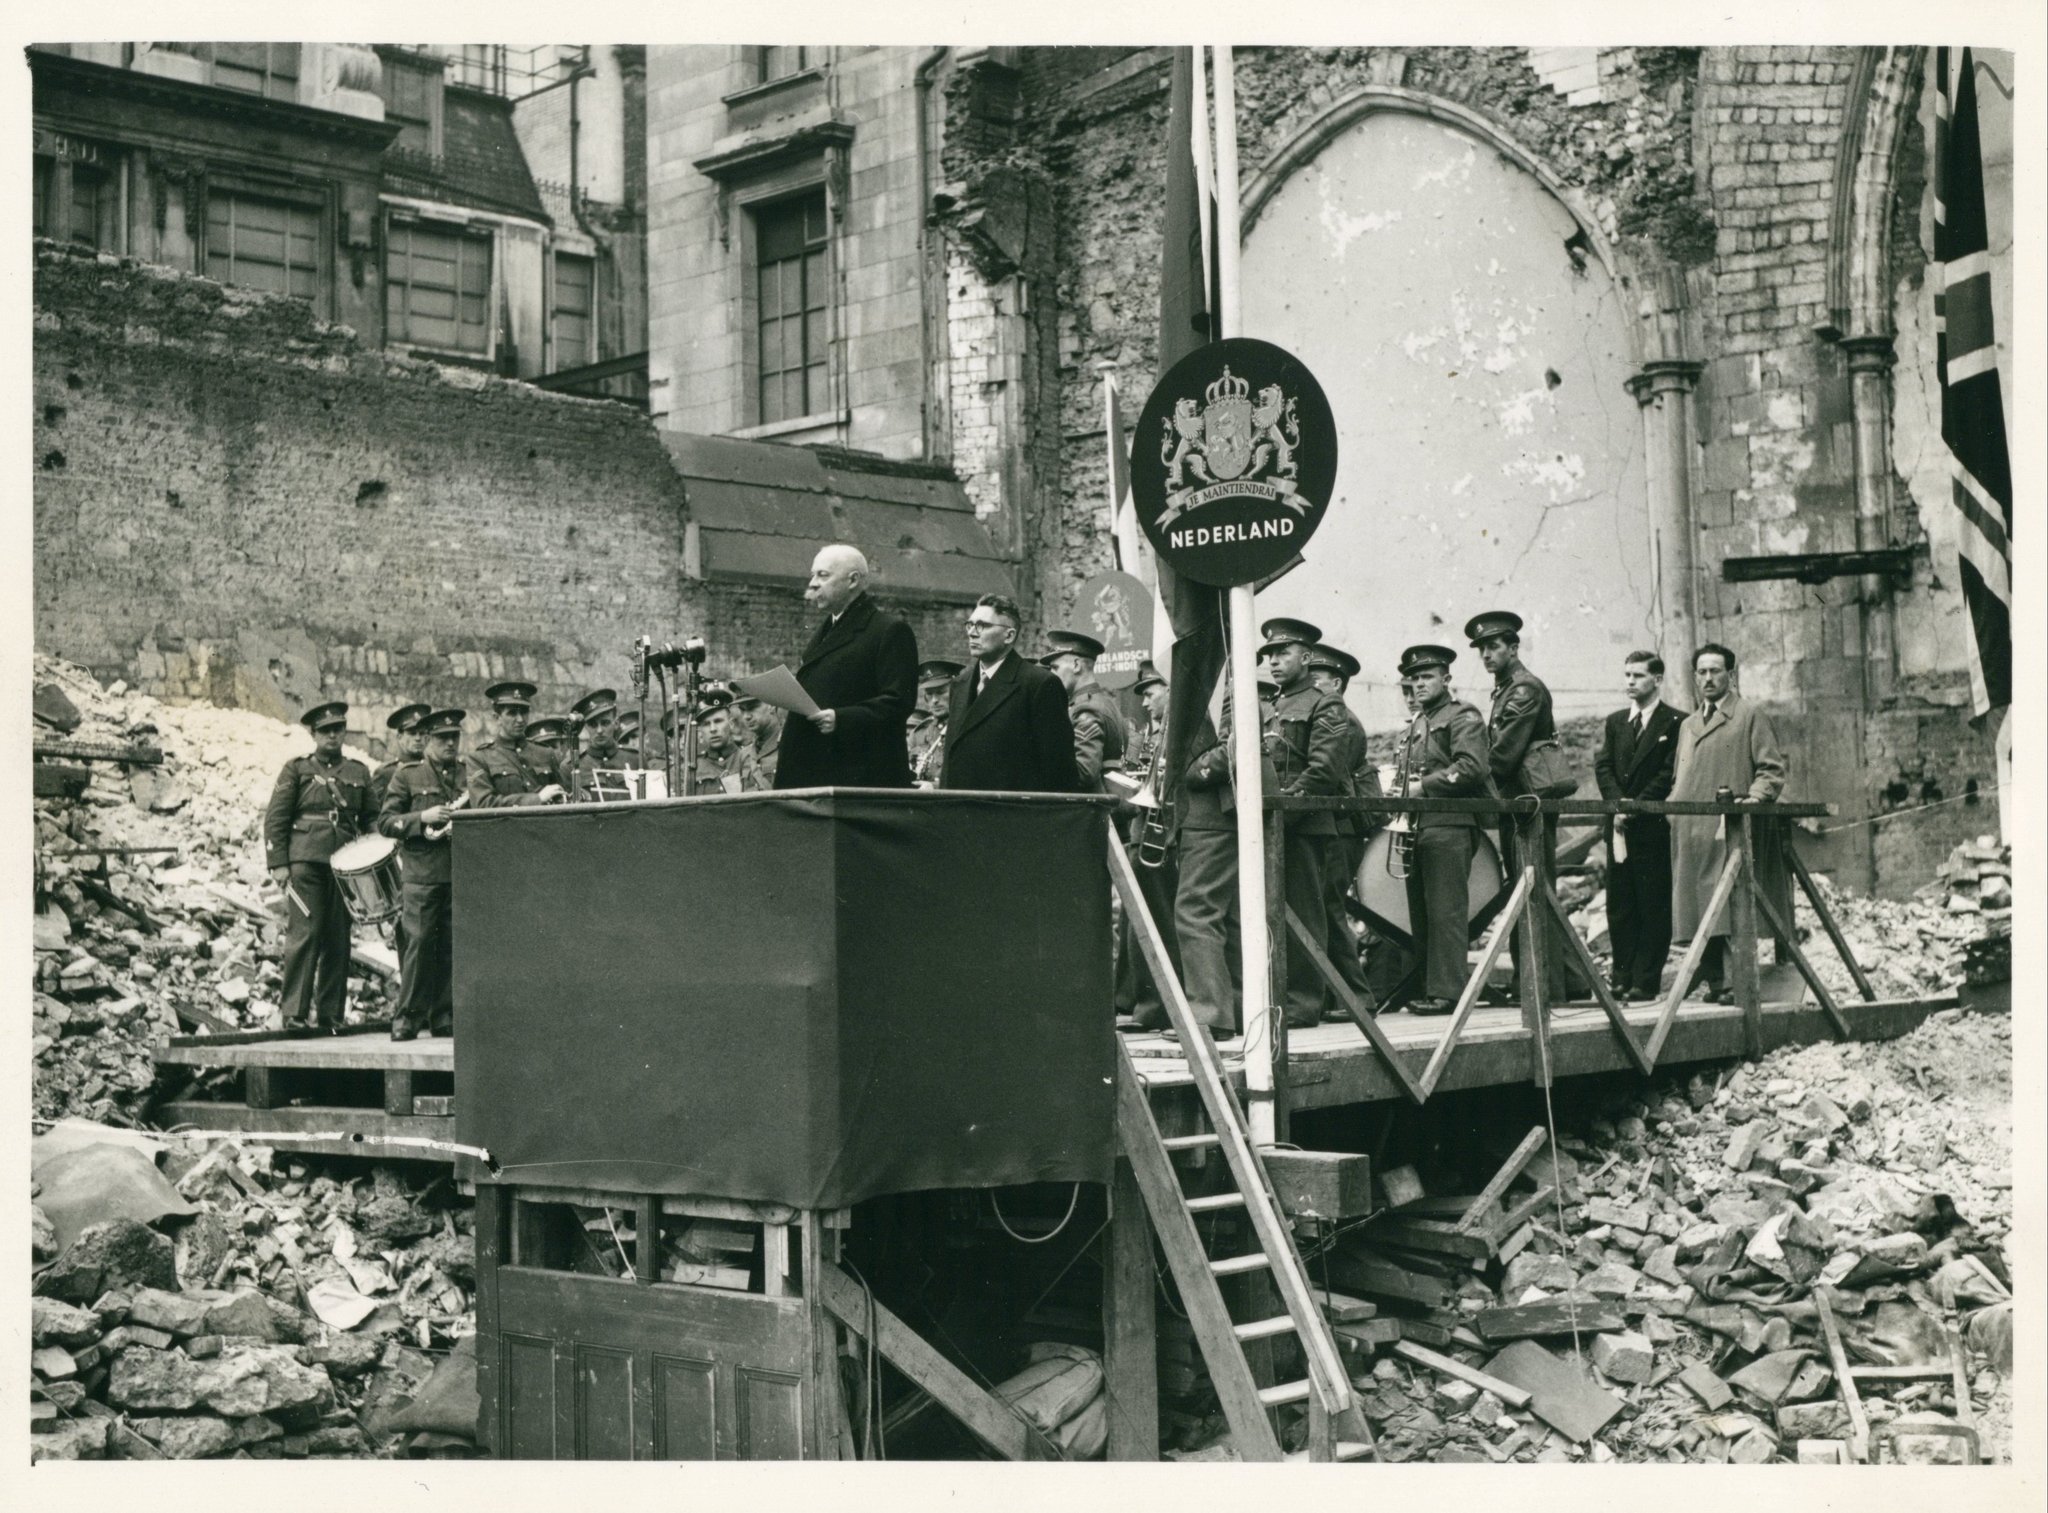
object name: documentary photograph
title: Minister-president Gerbrandy houdt een toespraak ter herdenking aan de Duitse inval op het terrein van de verwoeste Nederlandse kerk 'Austin Friars' te Londen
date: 1941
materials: photographic support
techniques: photography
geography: london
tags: the hague, pieter sjoerds gerbrandy, london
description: In de restanten van de totaal aan puin geschoten Nederlands Hervormde Kerk 'Austin Friars' te Londen houdt minister-president Gerbrandy een toespraak ter herdenking aan de Duitse inval in Nederland. Met op het podium naast Gerbrandy het wapen van Nederland bevestigd aan een vlaggenstok met daaraan wapperend de Nederlandse vlag, in de hoek de Engelse vlag. Op het podium een militaire kapel.